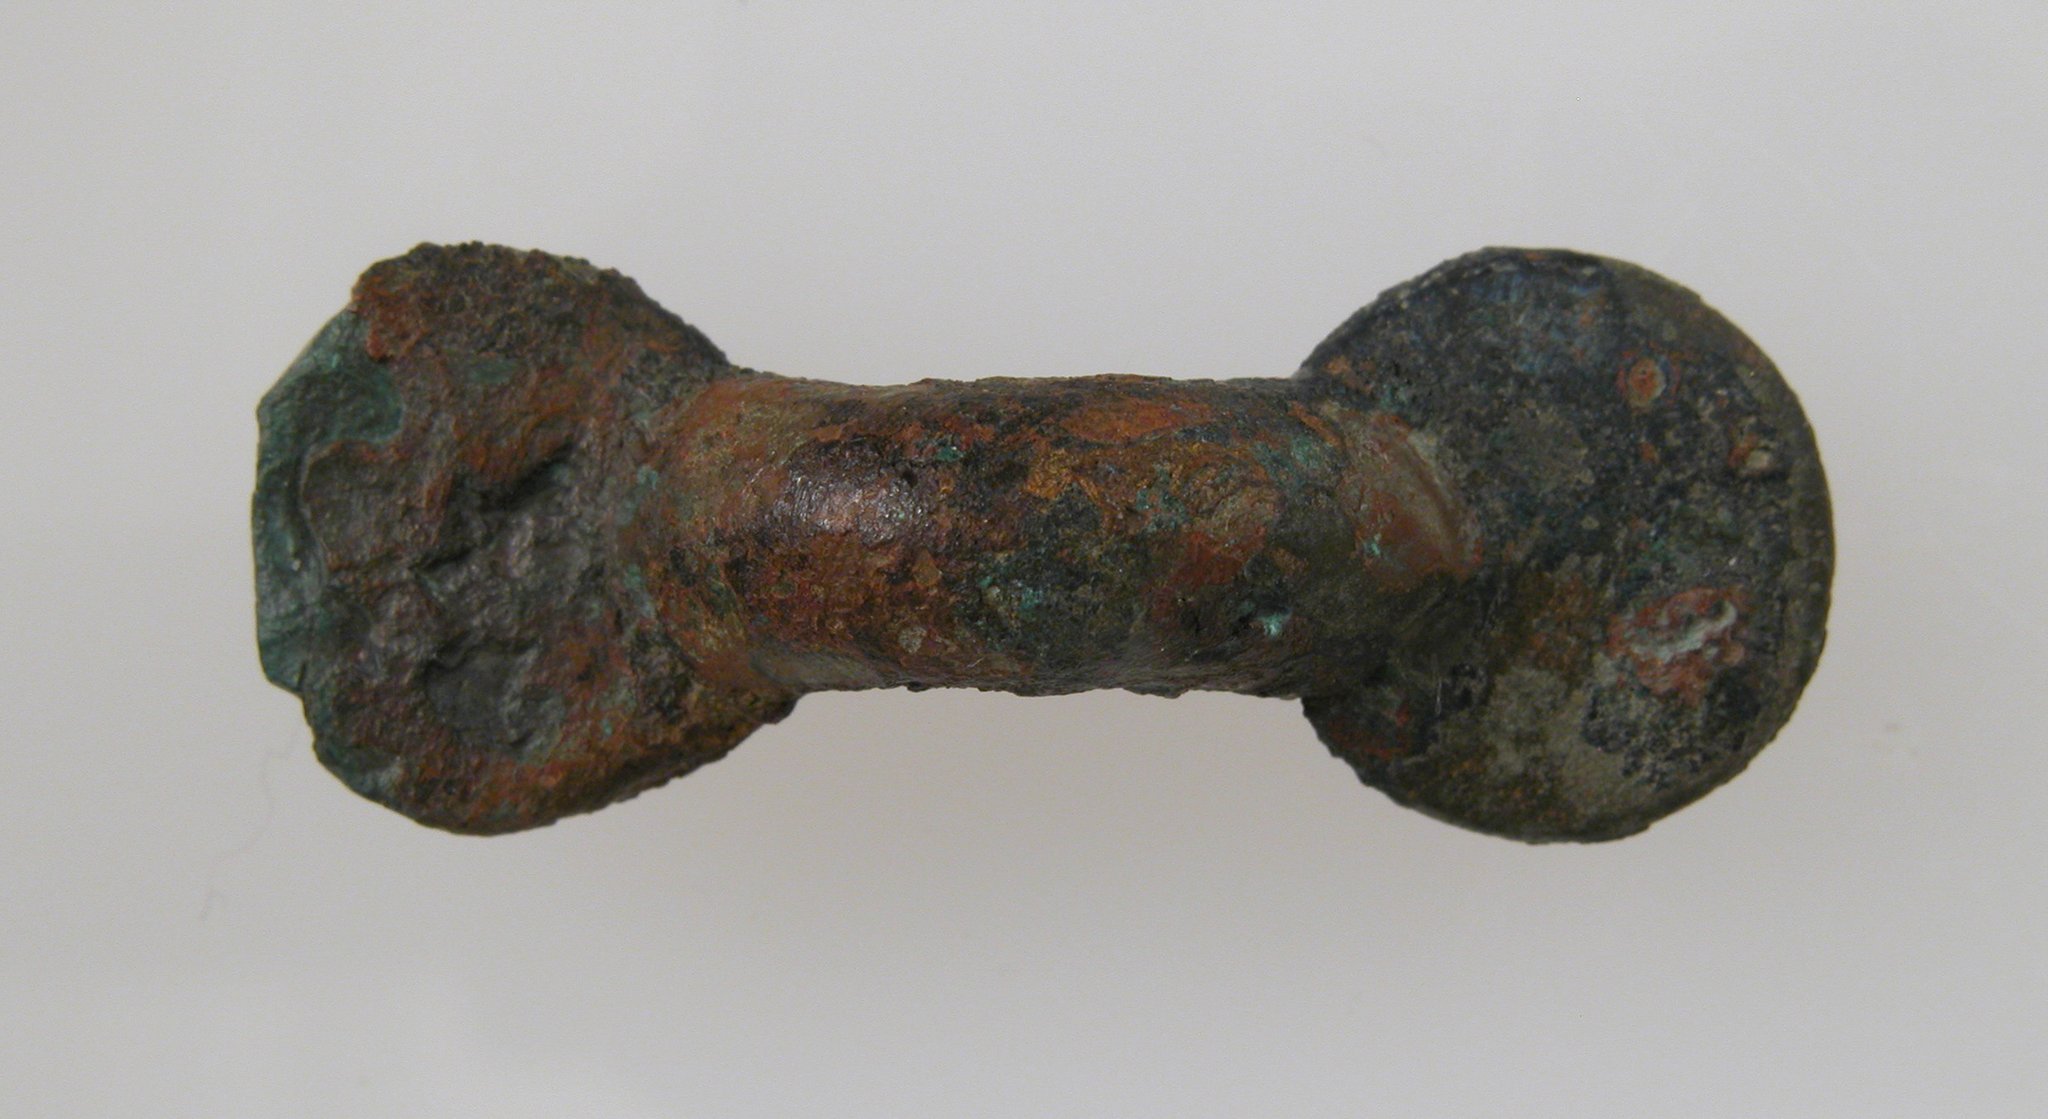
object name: brooch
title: Equal-Arm Brooch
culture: frankish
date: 650-750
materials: copper alloy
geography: germany